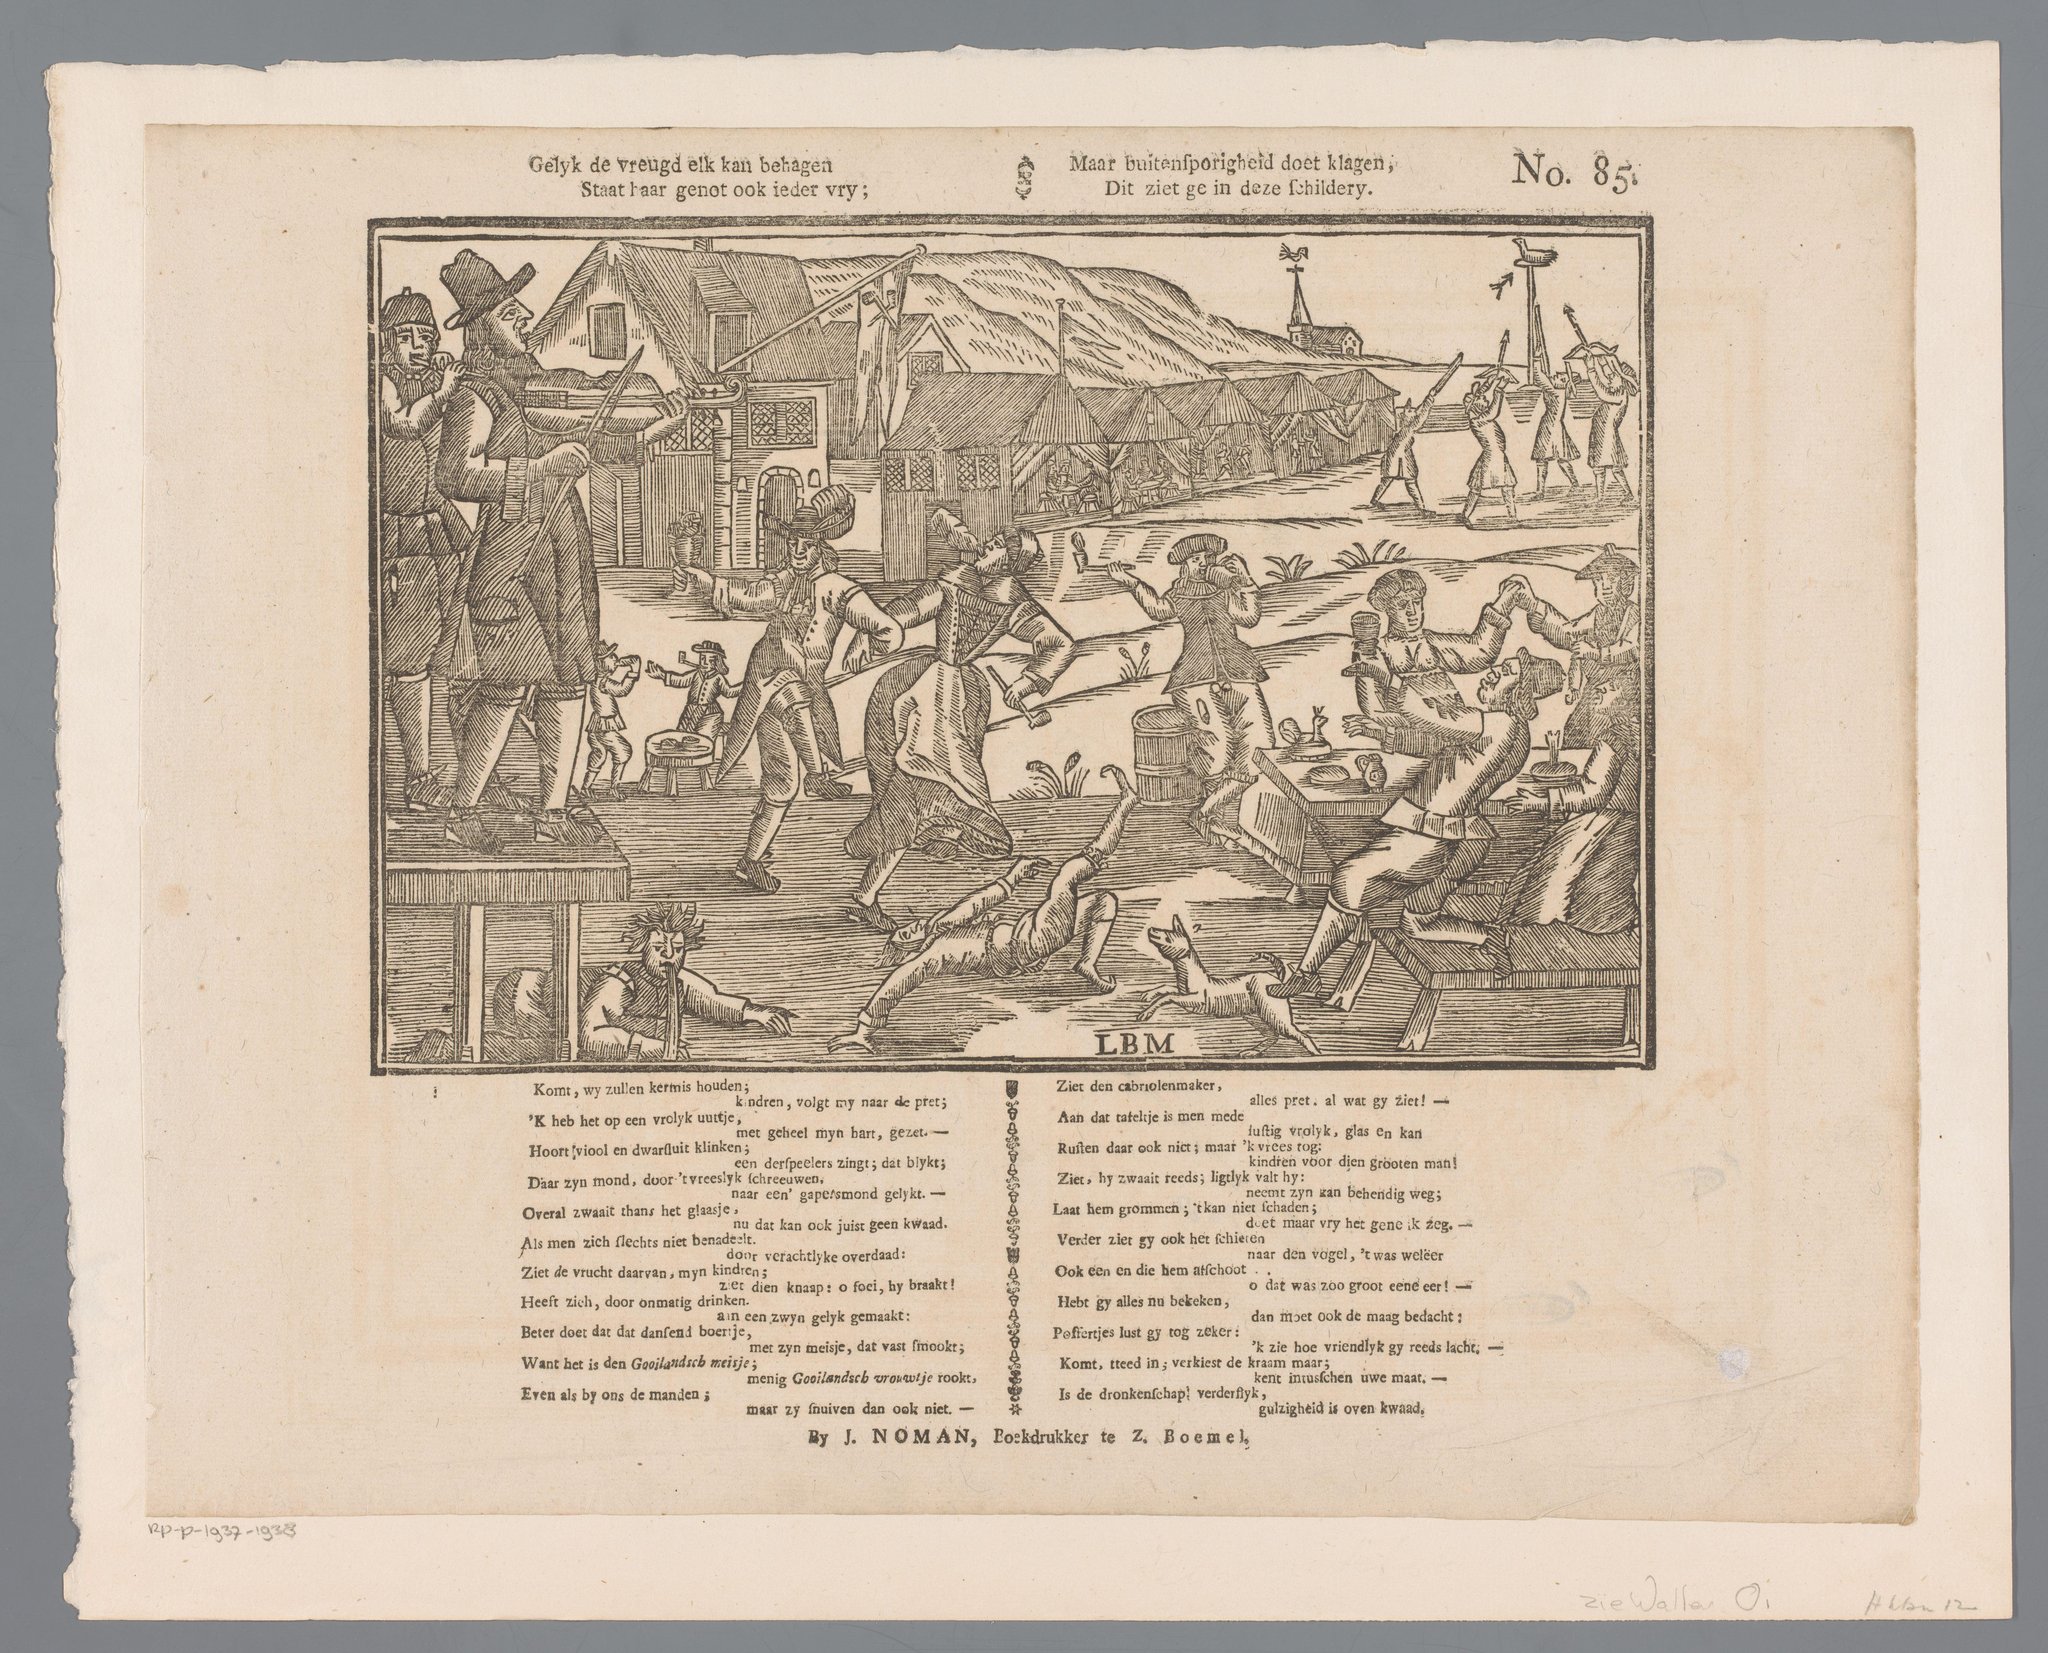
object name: popular print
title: Gelyk de vreugd elk kan behagen / Staat haar genot ook ieder vry; / Maar buitensporigheid doet klagen, / Dit ziet ge in deze schildery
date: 1806-1830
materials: paper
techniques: letterpress printing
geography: zaltbommel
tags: pleasure fair and circus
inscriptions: collector's mark: Lugt 2760, collector's mark: Lugt 2228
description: Blad met een kermistafereel, met onder andere dansende en etende mensen, een dronkenlap die moet overgeven en muzikanten. Onder de afbeelding een vers in twee kolommen. Genummerd rechtsboven: No. 85.